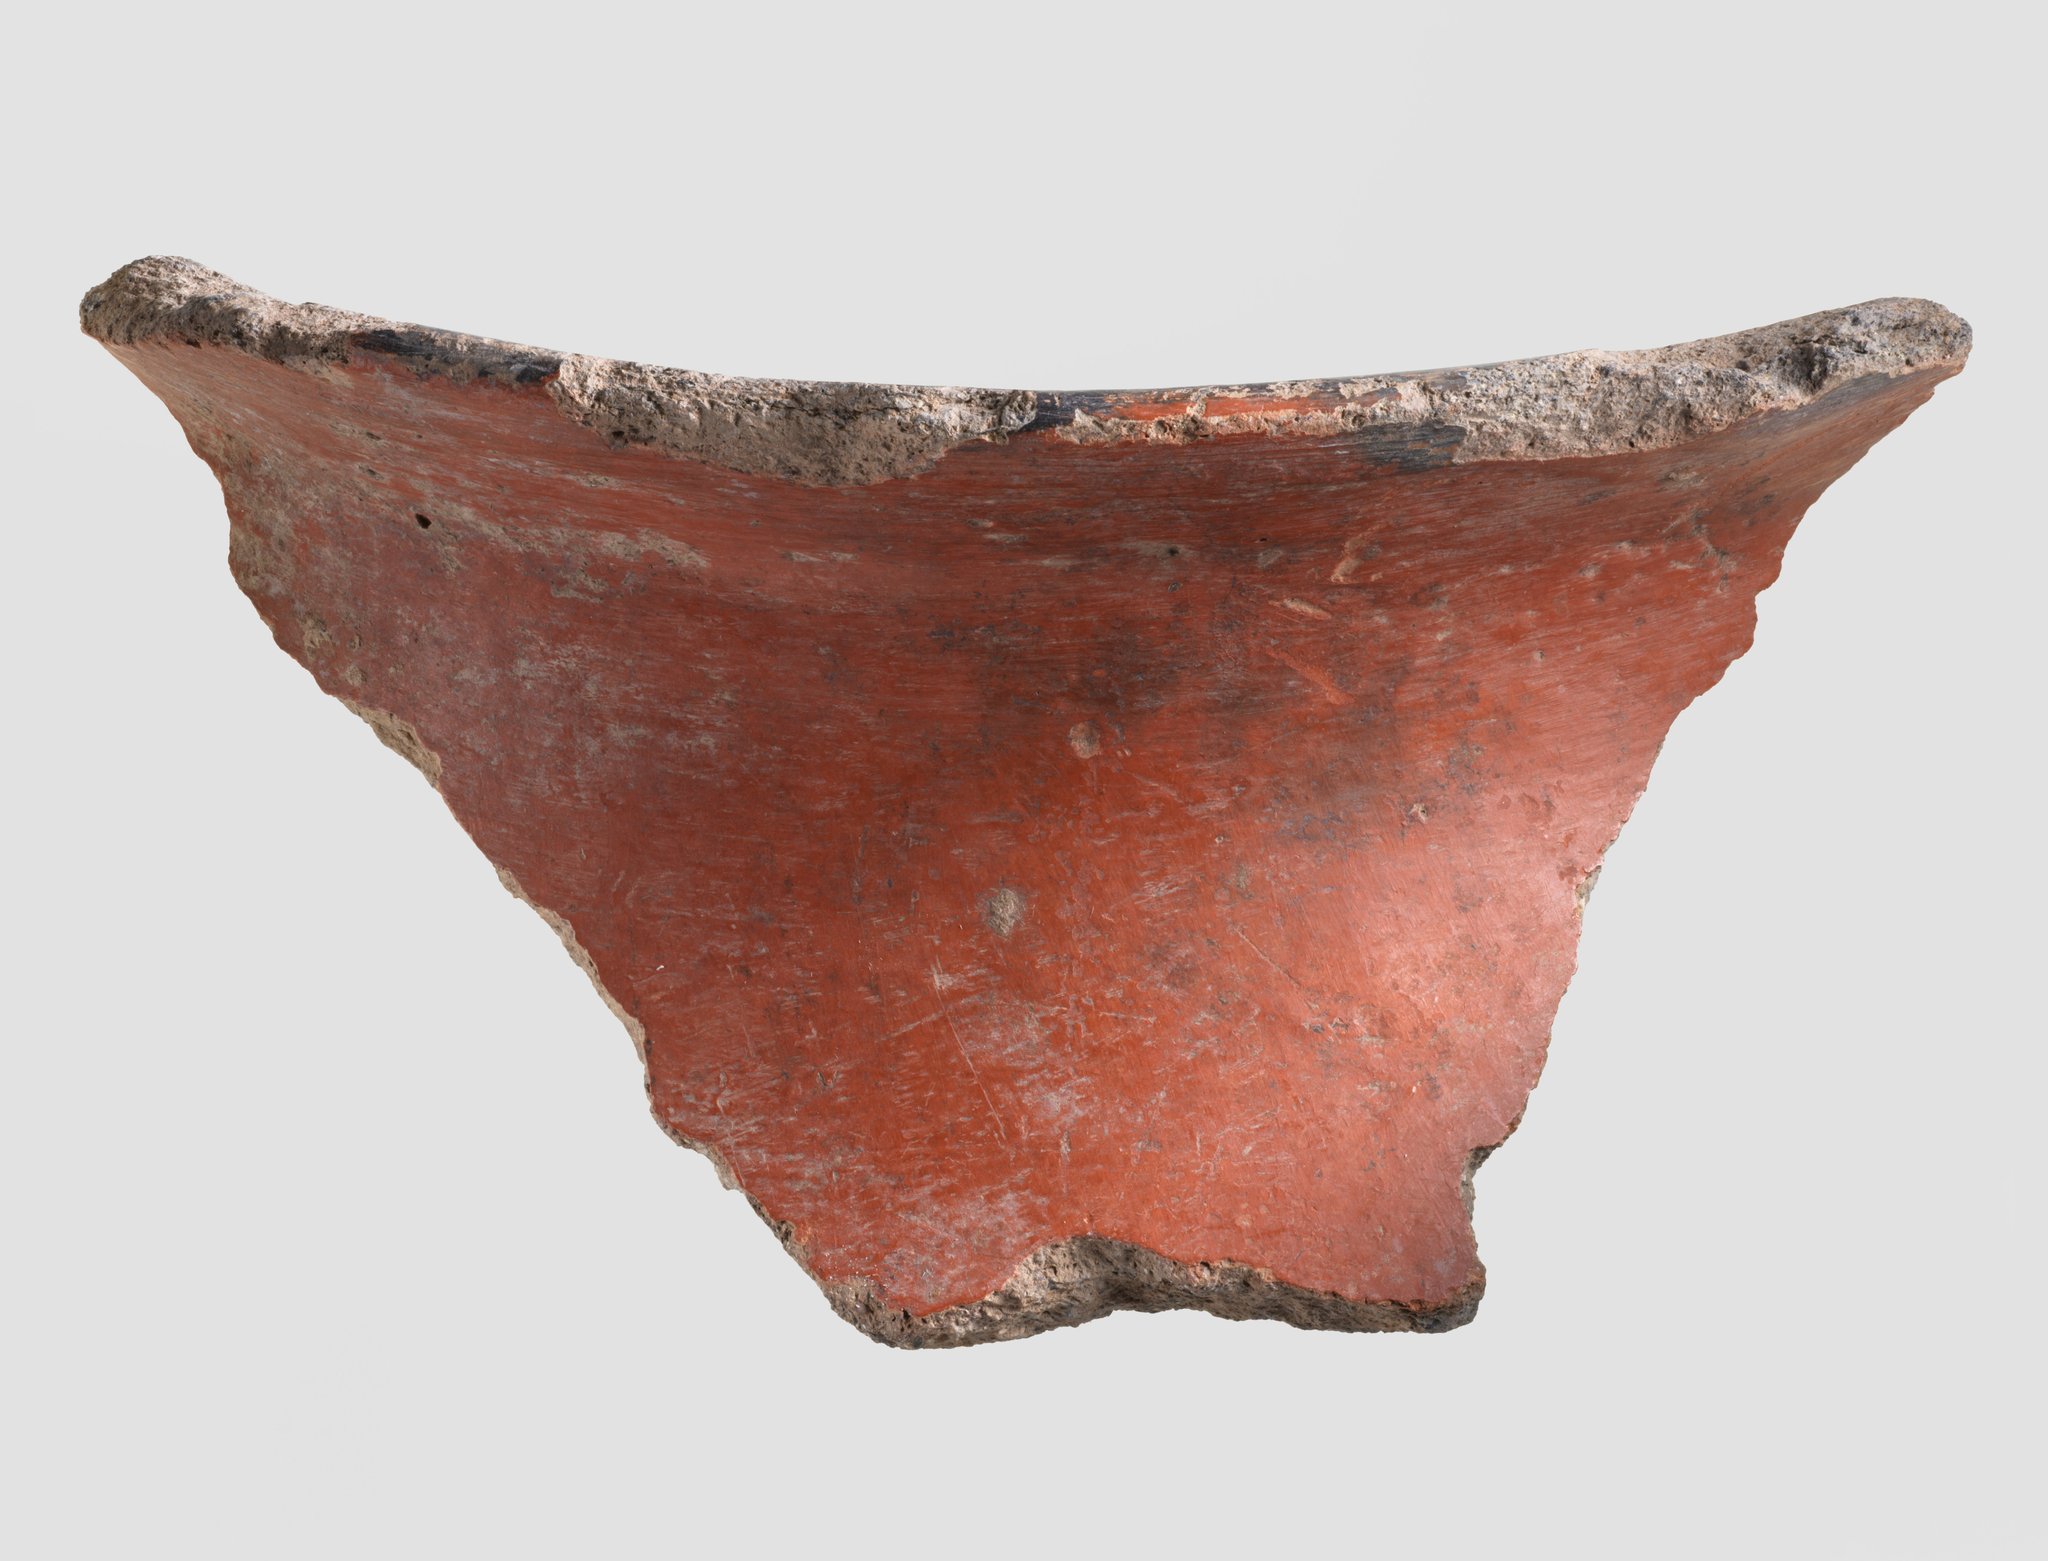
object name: sherd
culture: iranian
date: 3100-2500 BCE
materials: ceramic, paint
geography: iran